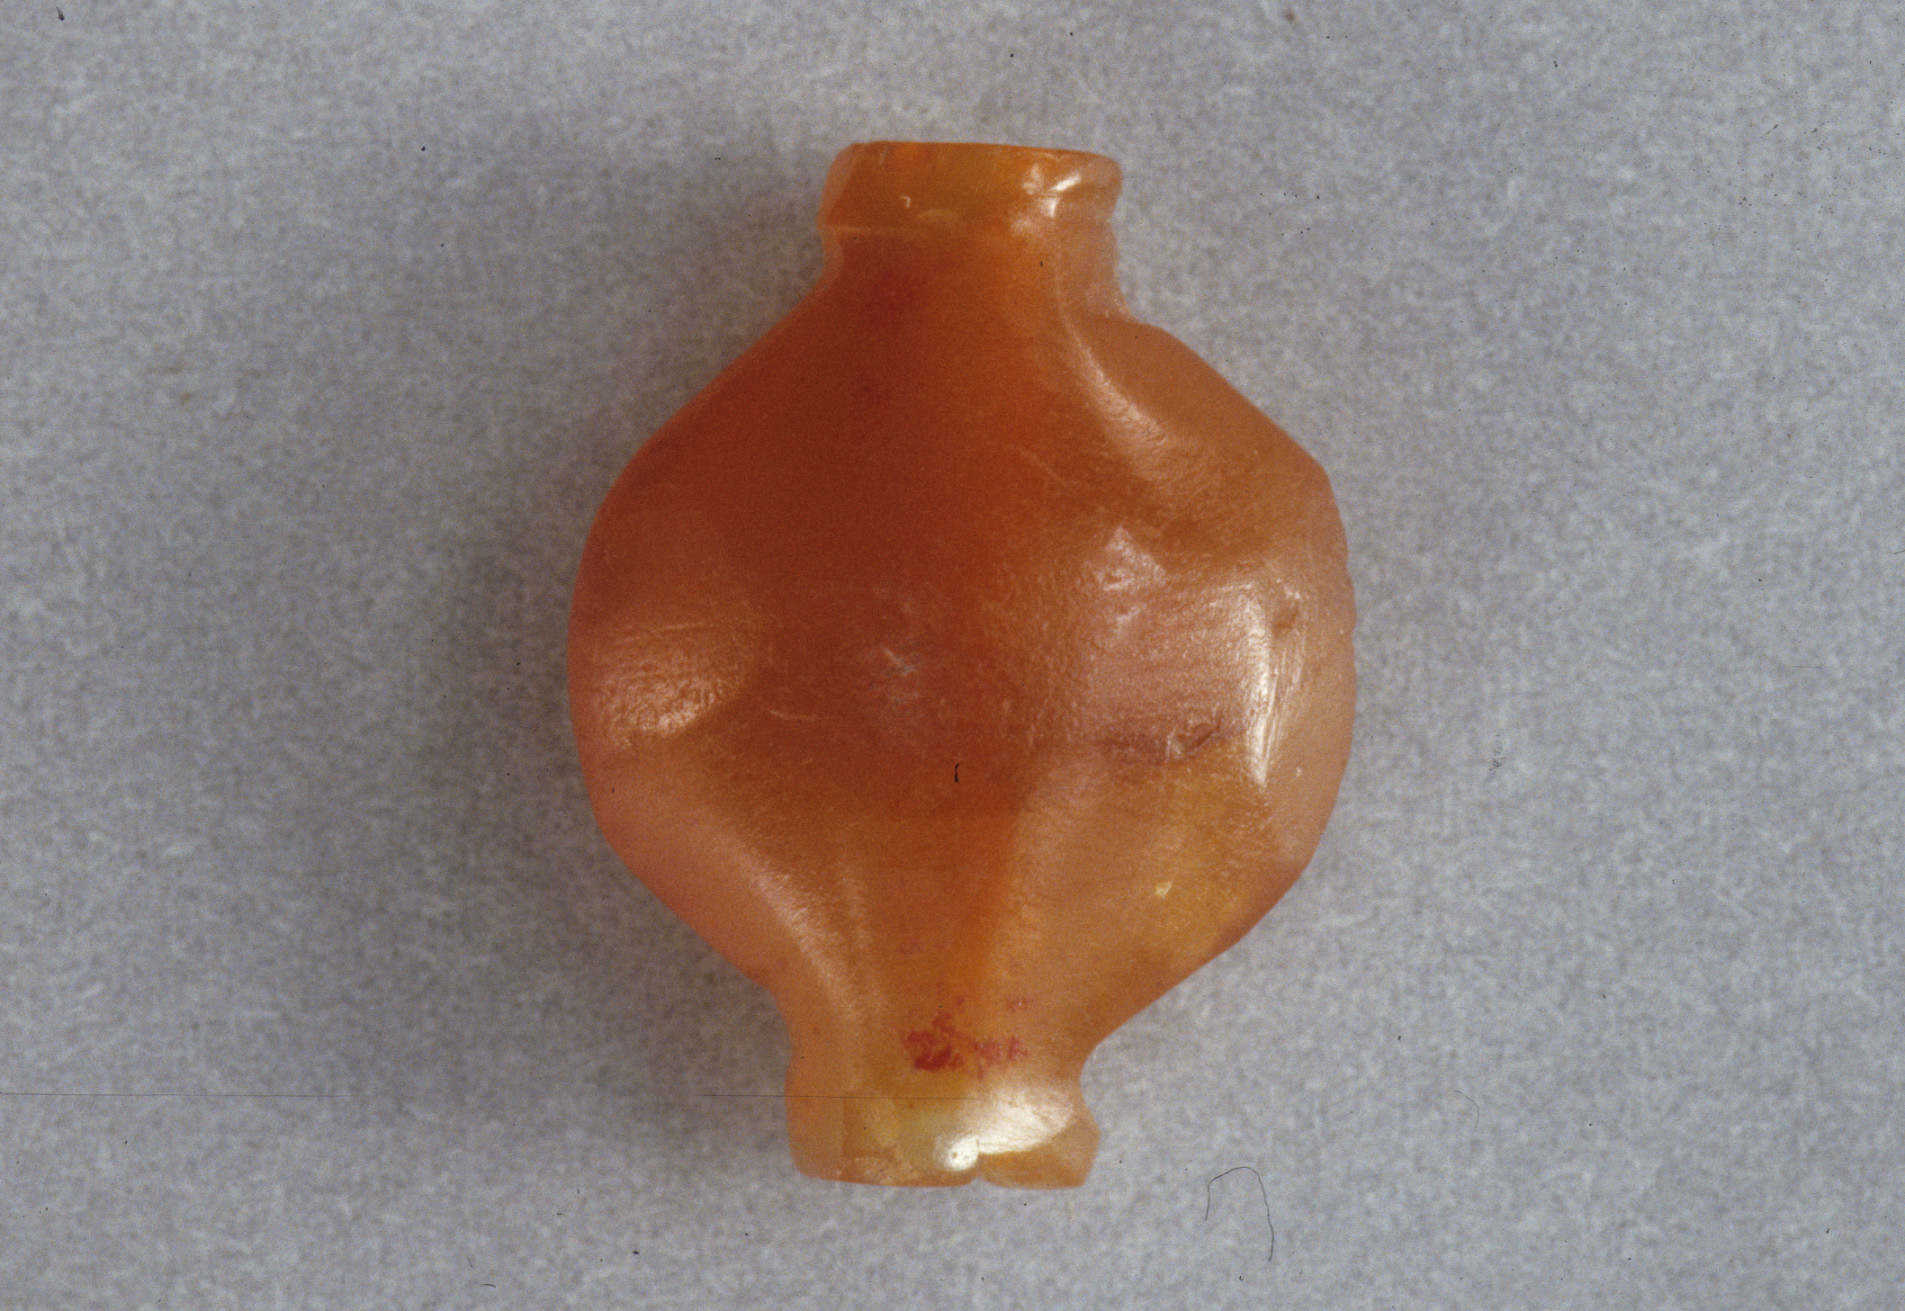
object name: bead, acacia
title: Bead in the Shape of an Acacia Seed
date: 1648-1540 BCE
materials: gemstone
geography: eastern delta